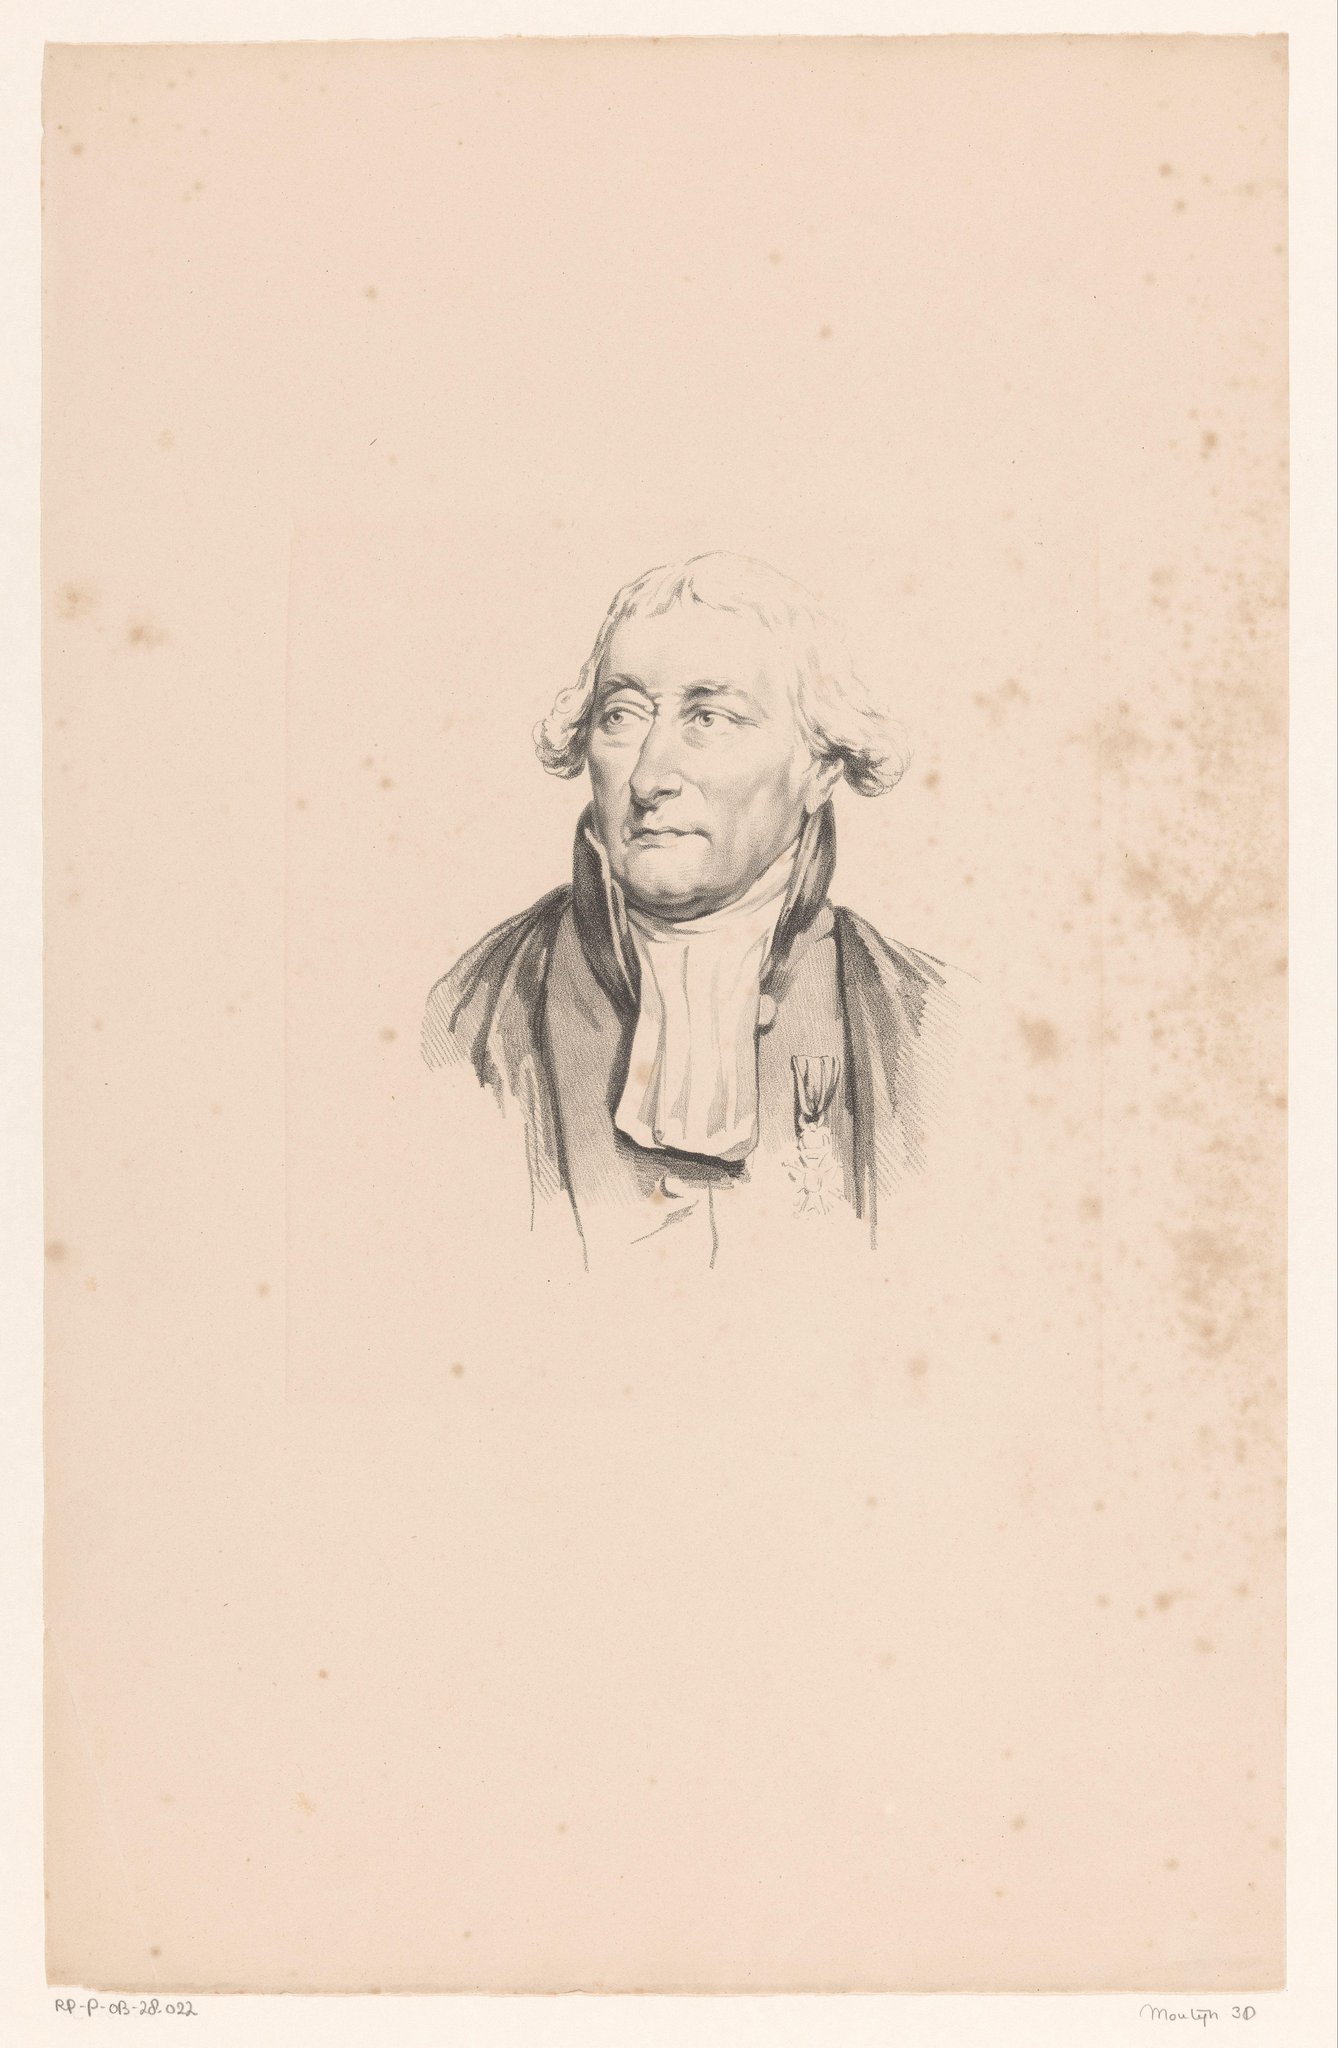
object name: print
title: Portret van professor Hendrik Constantijn Cras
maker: jean augustin daiwaille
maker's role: draughtsman, print maker, printer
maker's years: 1786-1850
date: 1809-1850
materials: paper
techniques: lithograph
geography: amsterdam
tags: historical persons (+ head (and shoulders) (portrait)), knighthood order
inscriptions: collector's mark: Lugt 2228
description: De geportretteerde kijkt naar links. Hij draagt een witte bef en een ridderorde op zijn borst.